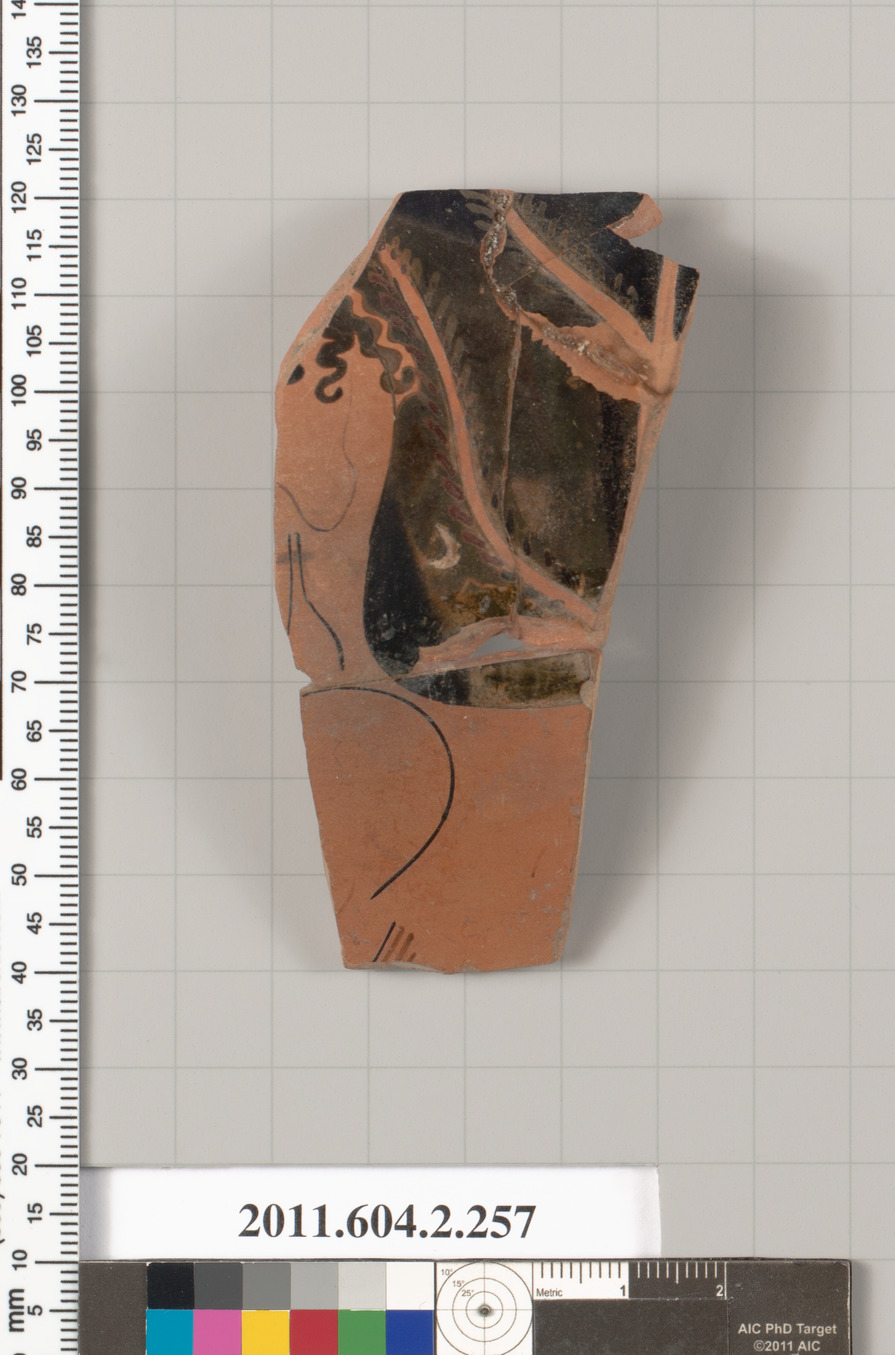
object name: stamnos fragment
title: Terracotta fragment of a stamnos (jar)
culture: greek, attic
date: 475-451 BCE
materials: terracotta